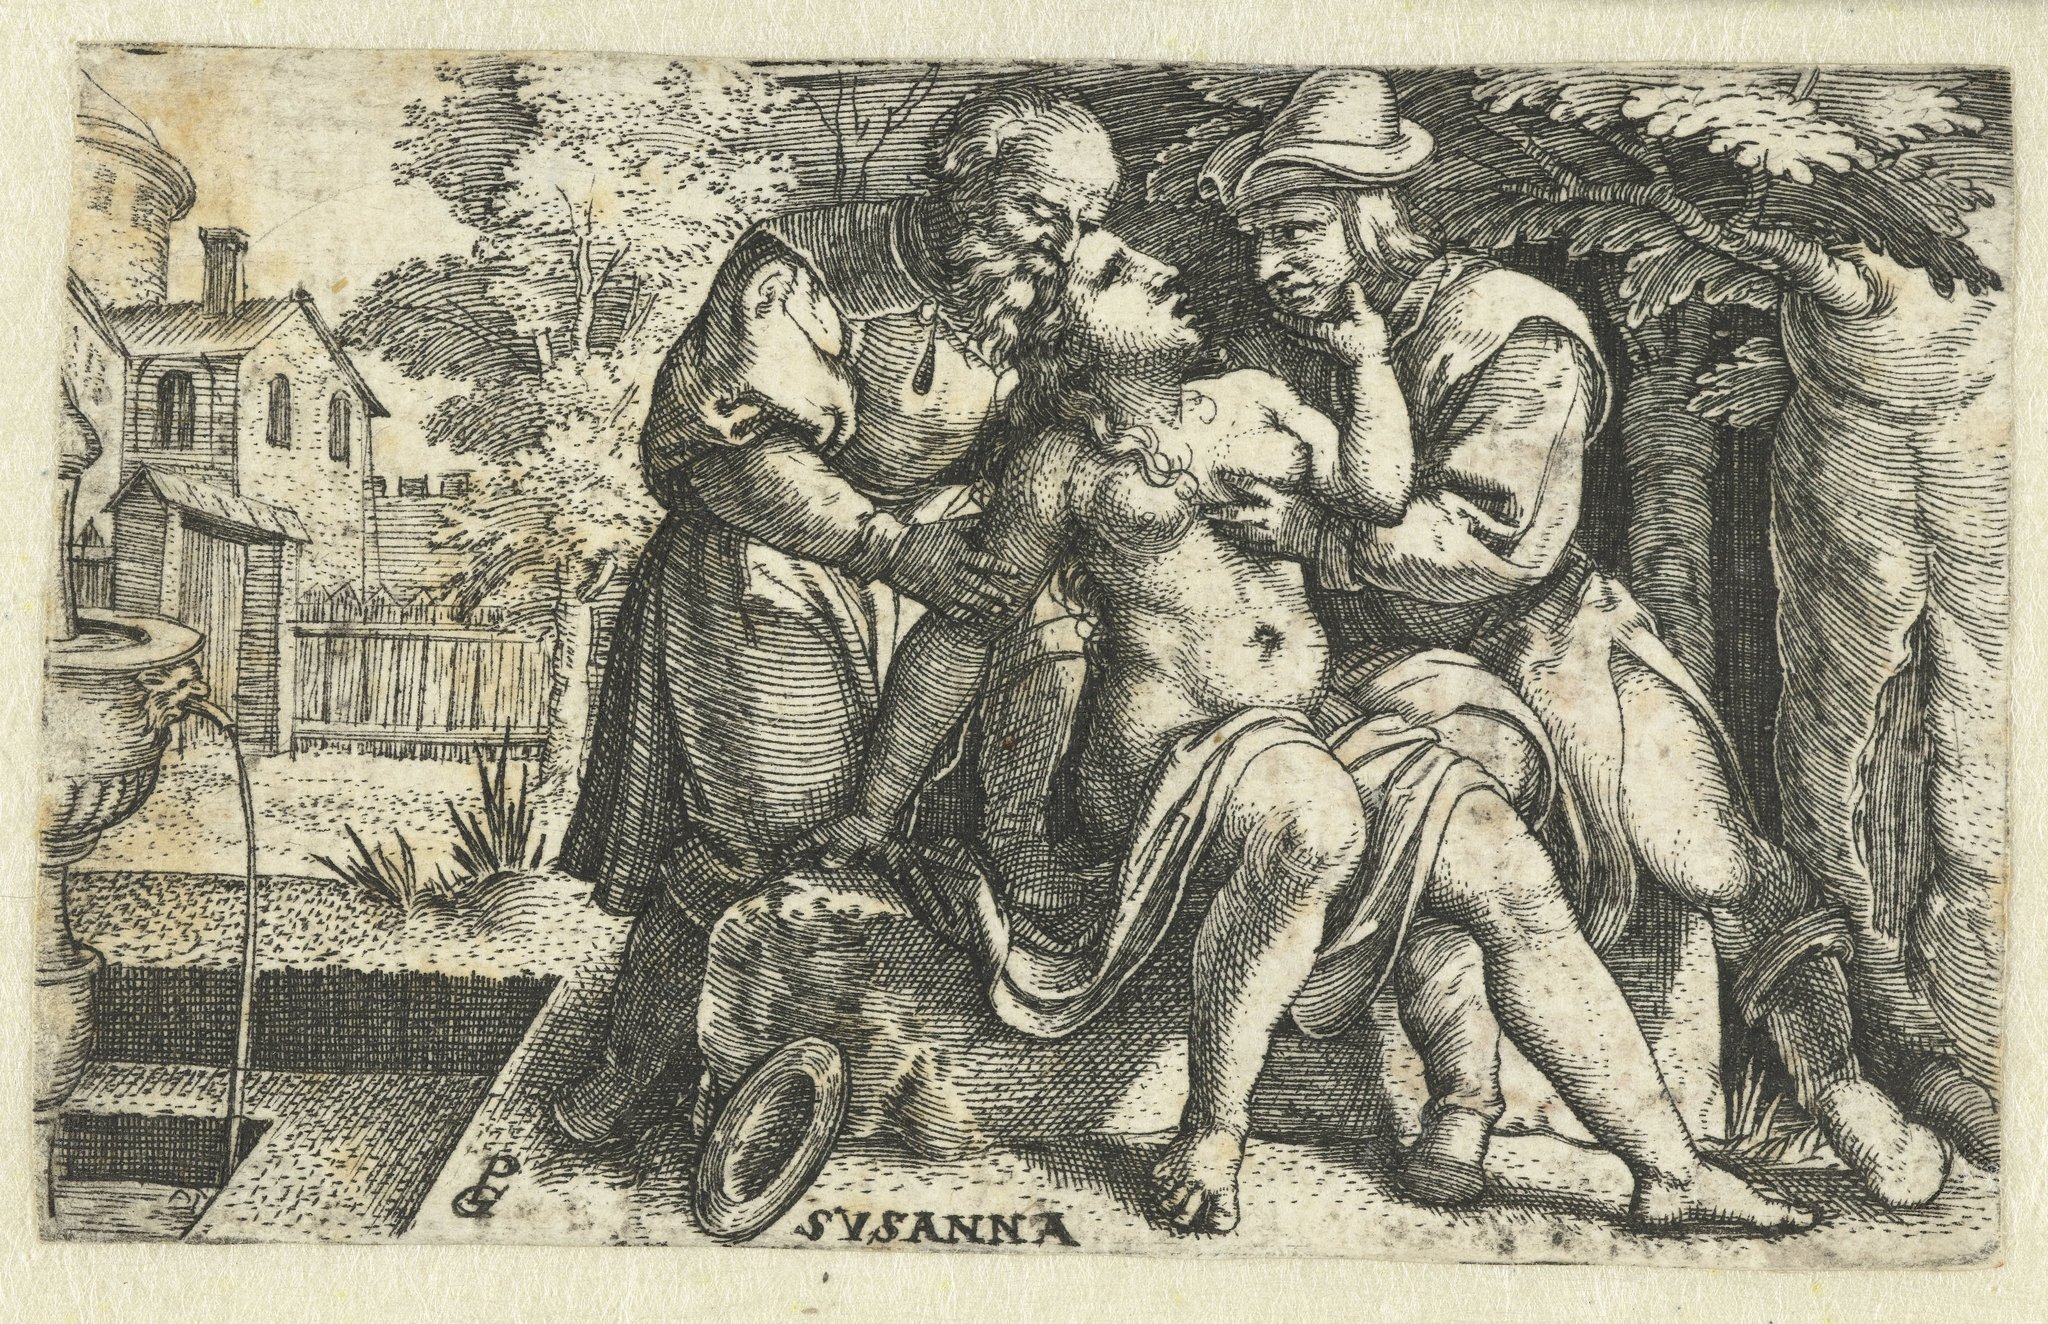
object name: print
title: Svsanna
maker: georg pencz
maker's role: draughtsman, painter, print maker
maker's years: 1500-1550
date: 1530-1534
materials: paper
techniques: engraving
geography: germany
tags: the elders making advances towards susanna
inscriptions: collector's mark: Lugt 240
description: De naakte Susanna wordt in haar tuin onaangenaam verrast door twee oudsten die eisen dat zij zich aan hen geeft onder het dreigement dat de twee mannen haar zullen beschuldigen van overspel. Zij verzet zich tegen hen.